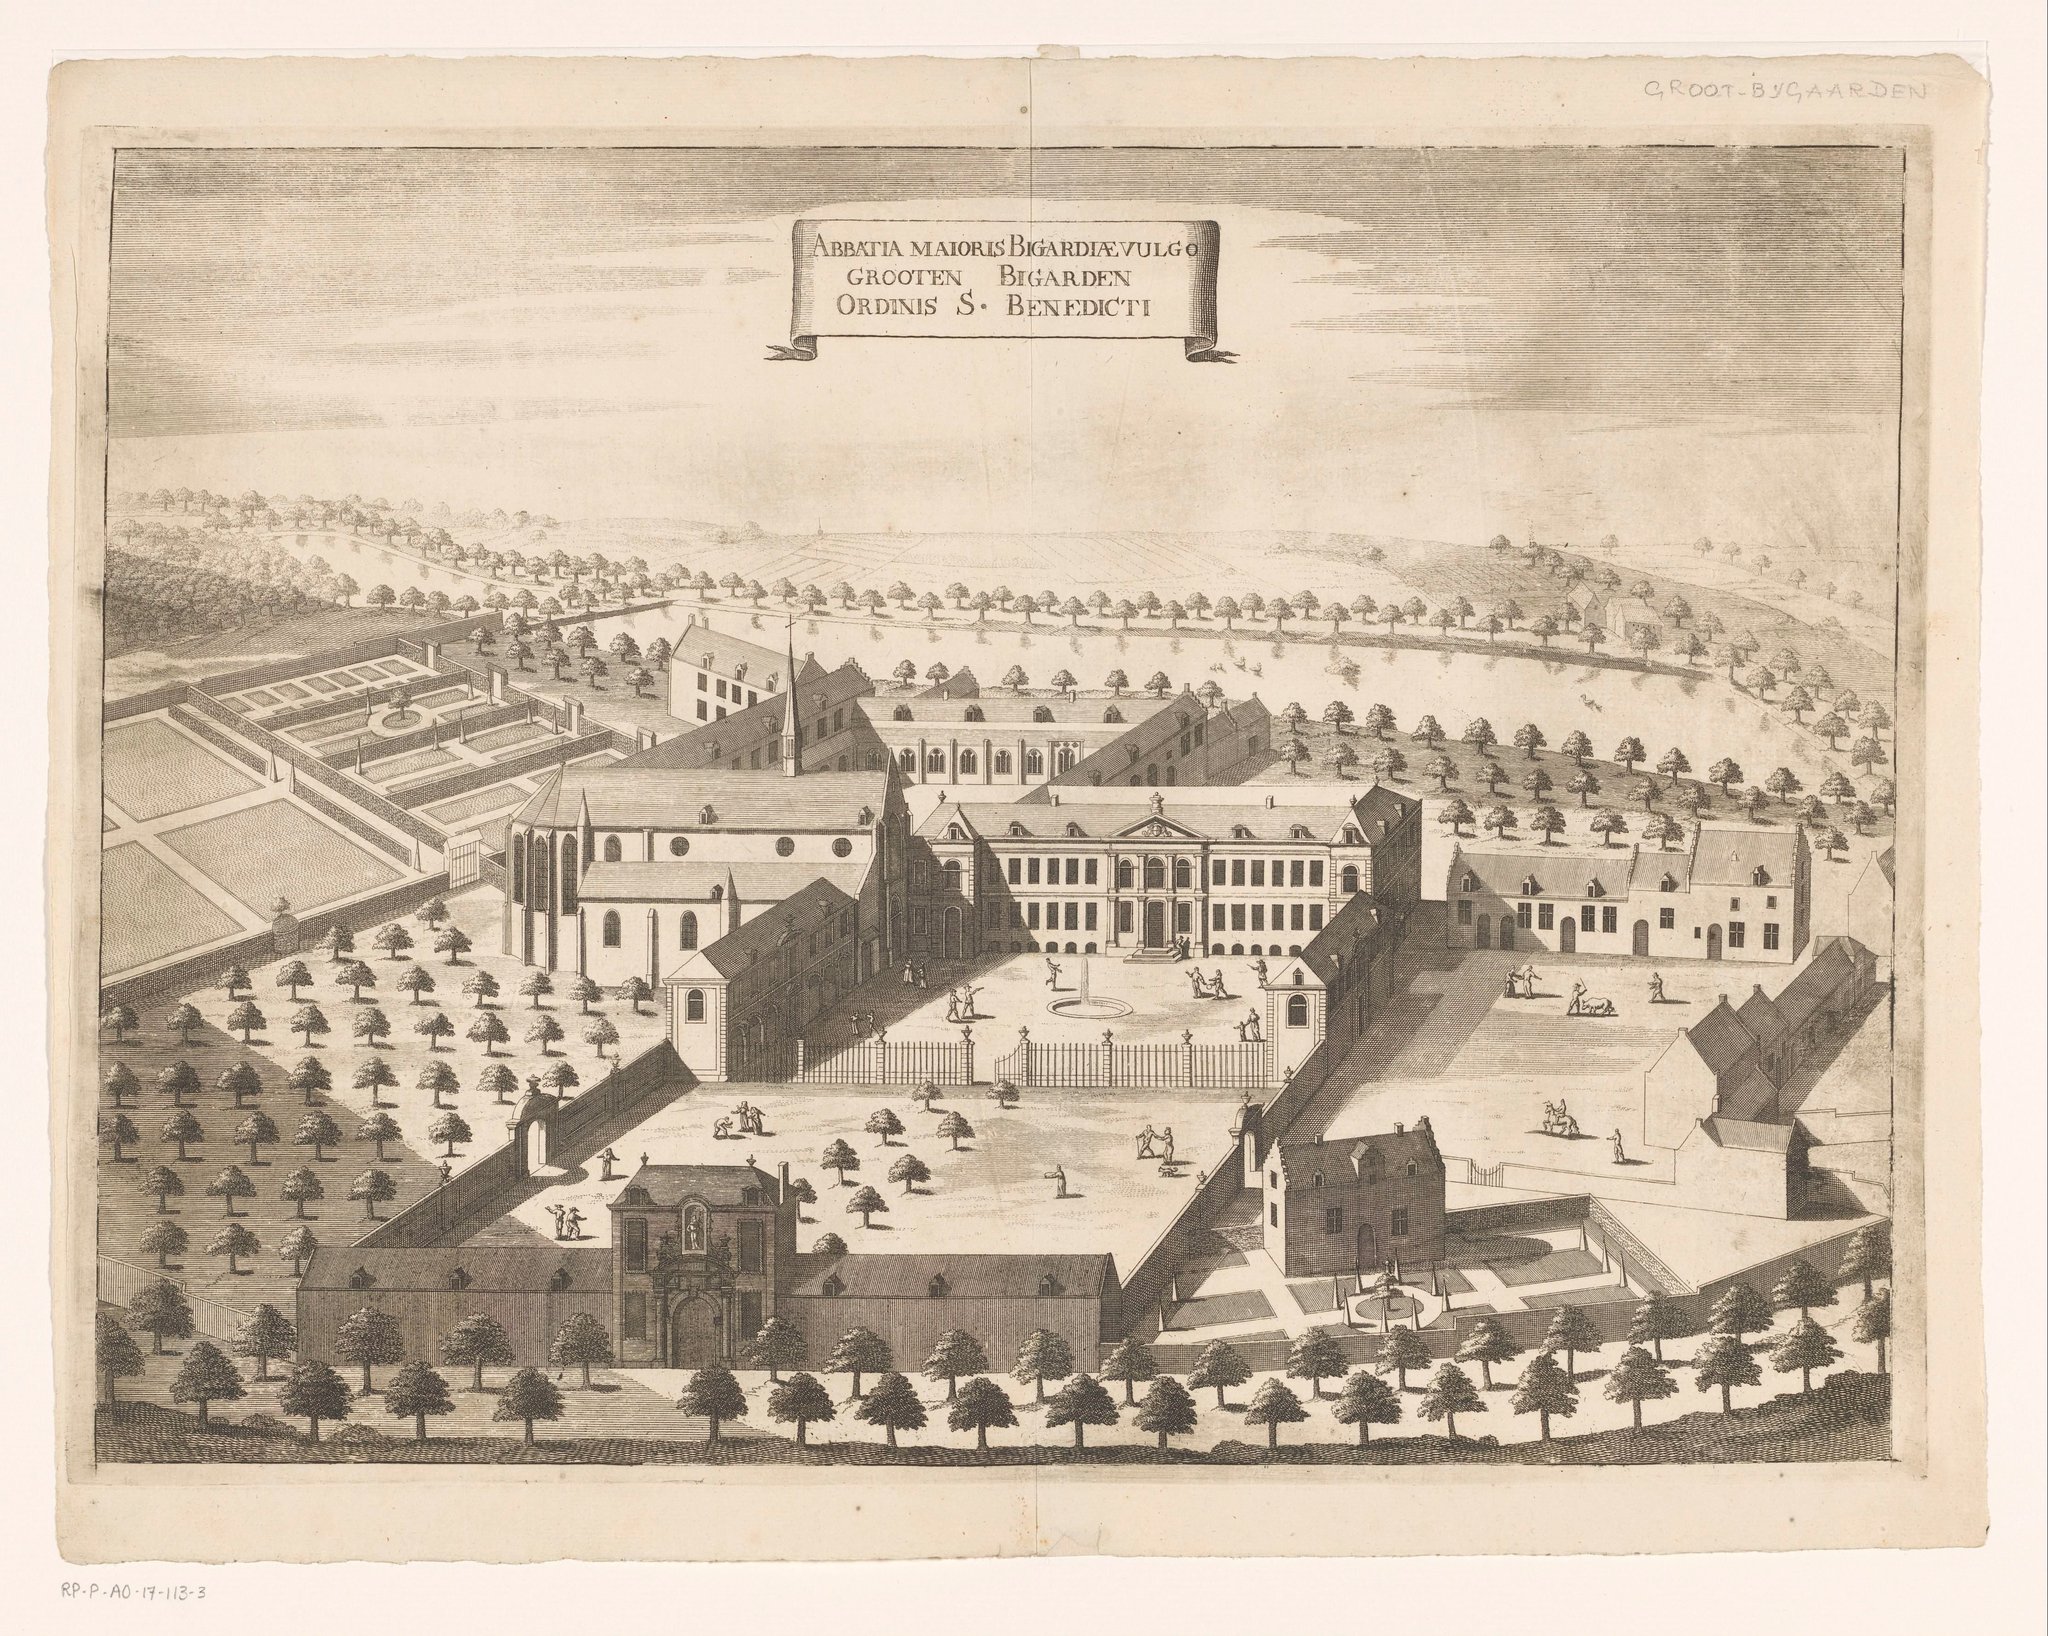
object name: book illustration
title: Abbatia Maioris Bigardiae vulgo Grooten Bigarden ordinis S. Benedicti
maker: Anonymous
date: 1726-1734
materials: paper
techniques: etching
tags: abbey, monastery, convent ~ roman catholic church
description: Prent ook gebruikt in: Sanderus, Antonius. Groot kerkelyk toneel des Hertogdoms van Brabant (...). Den Haag: Christiaan van Lom, 1727. En in: Sanderus, Antonius. Antonii Sanderi presbyteri Chorographia sacra Brabantiæ. 3 delen. Den Haag: Christiaan van Lom, 1726-1727, dl. 1 (1726). En in: Sanderus, Antonius. Le grand theatre sacré du duché de Brabant (...). 4 delen. Den Haag: Gerard Block, 1729-1734.